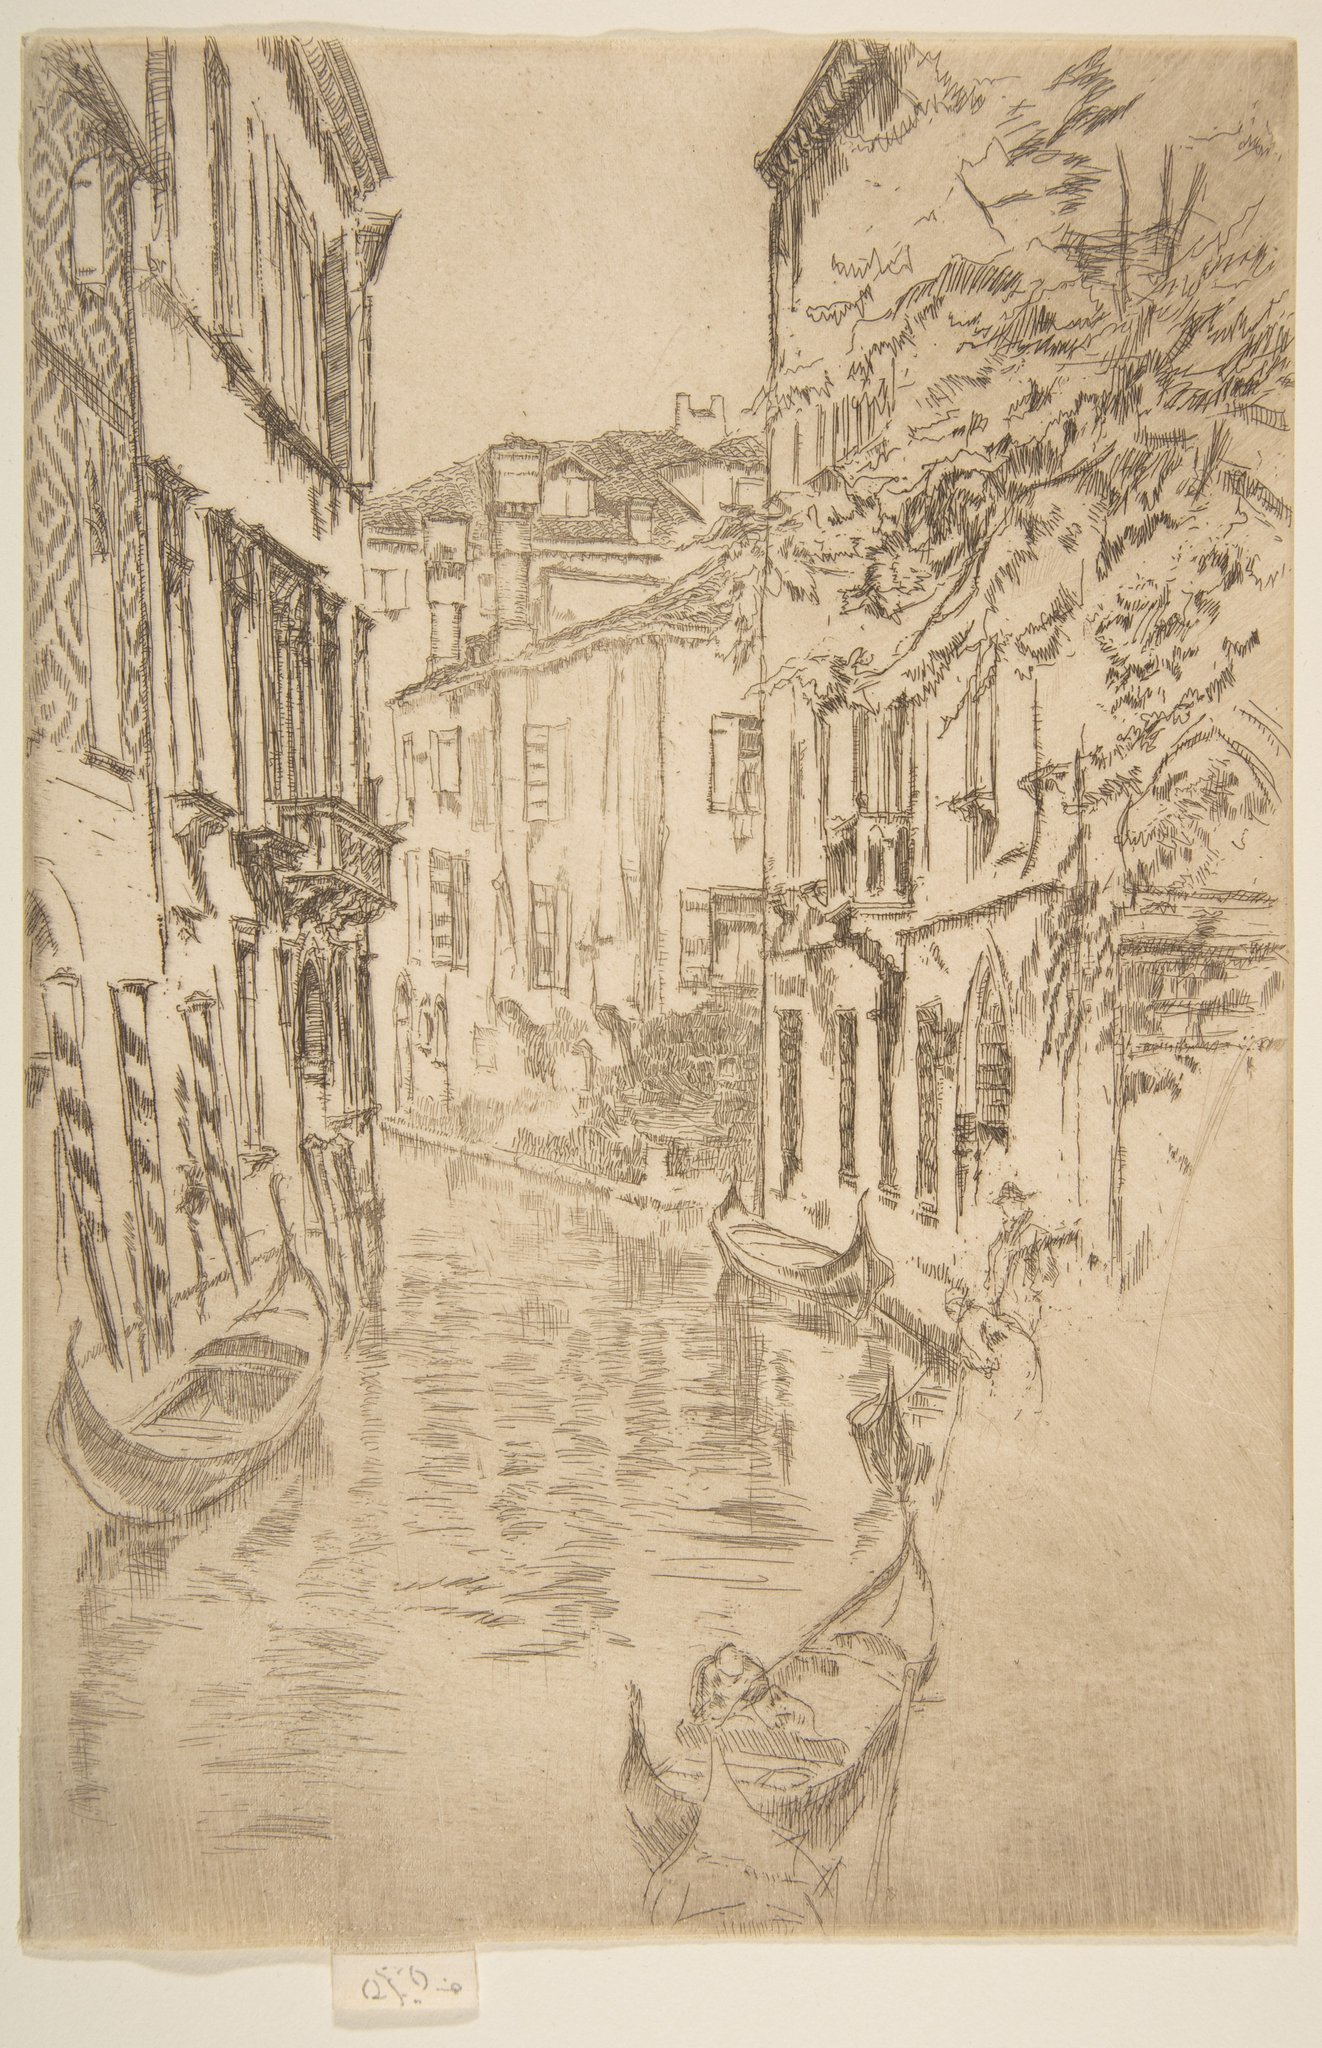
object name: print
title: Quiet Canal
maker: james mcneill whistler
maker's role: artist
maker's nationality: american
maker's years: 1834-1903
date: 1879-1880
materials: ink, paper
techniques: drypoint, etching, printing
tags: buildings,canals,boats,venice